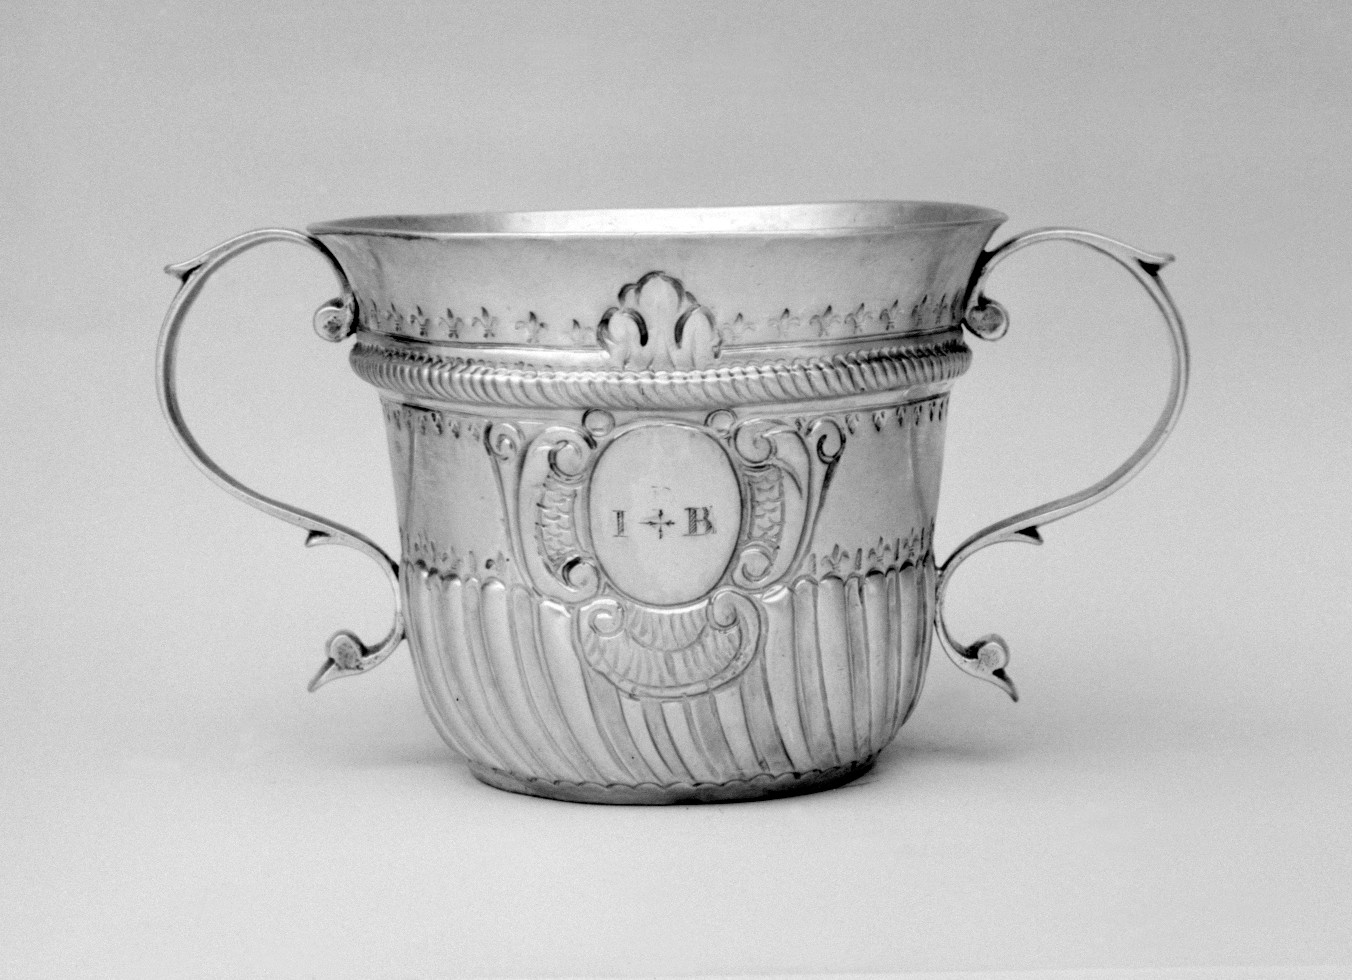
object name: cup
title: Two-handled cup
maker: robert pilkington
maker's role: maker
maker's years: 1720-1739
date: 1729-1730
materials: silver